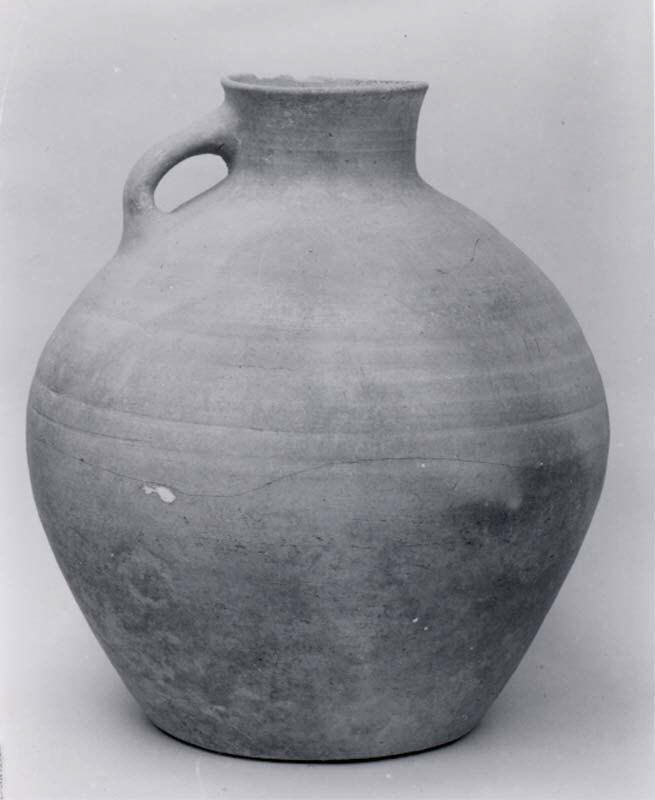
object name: jug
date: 2000-1001 BCE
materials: ceramic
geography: iran